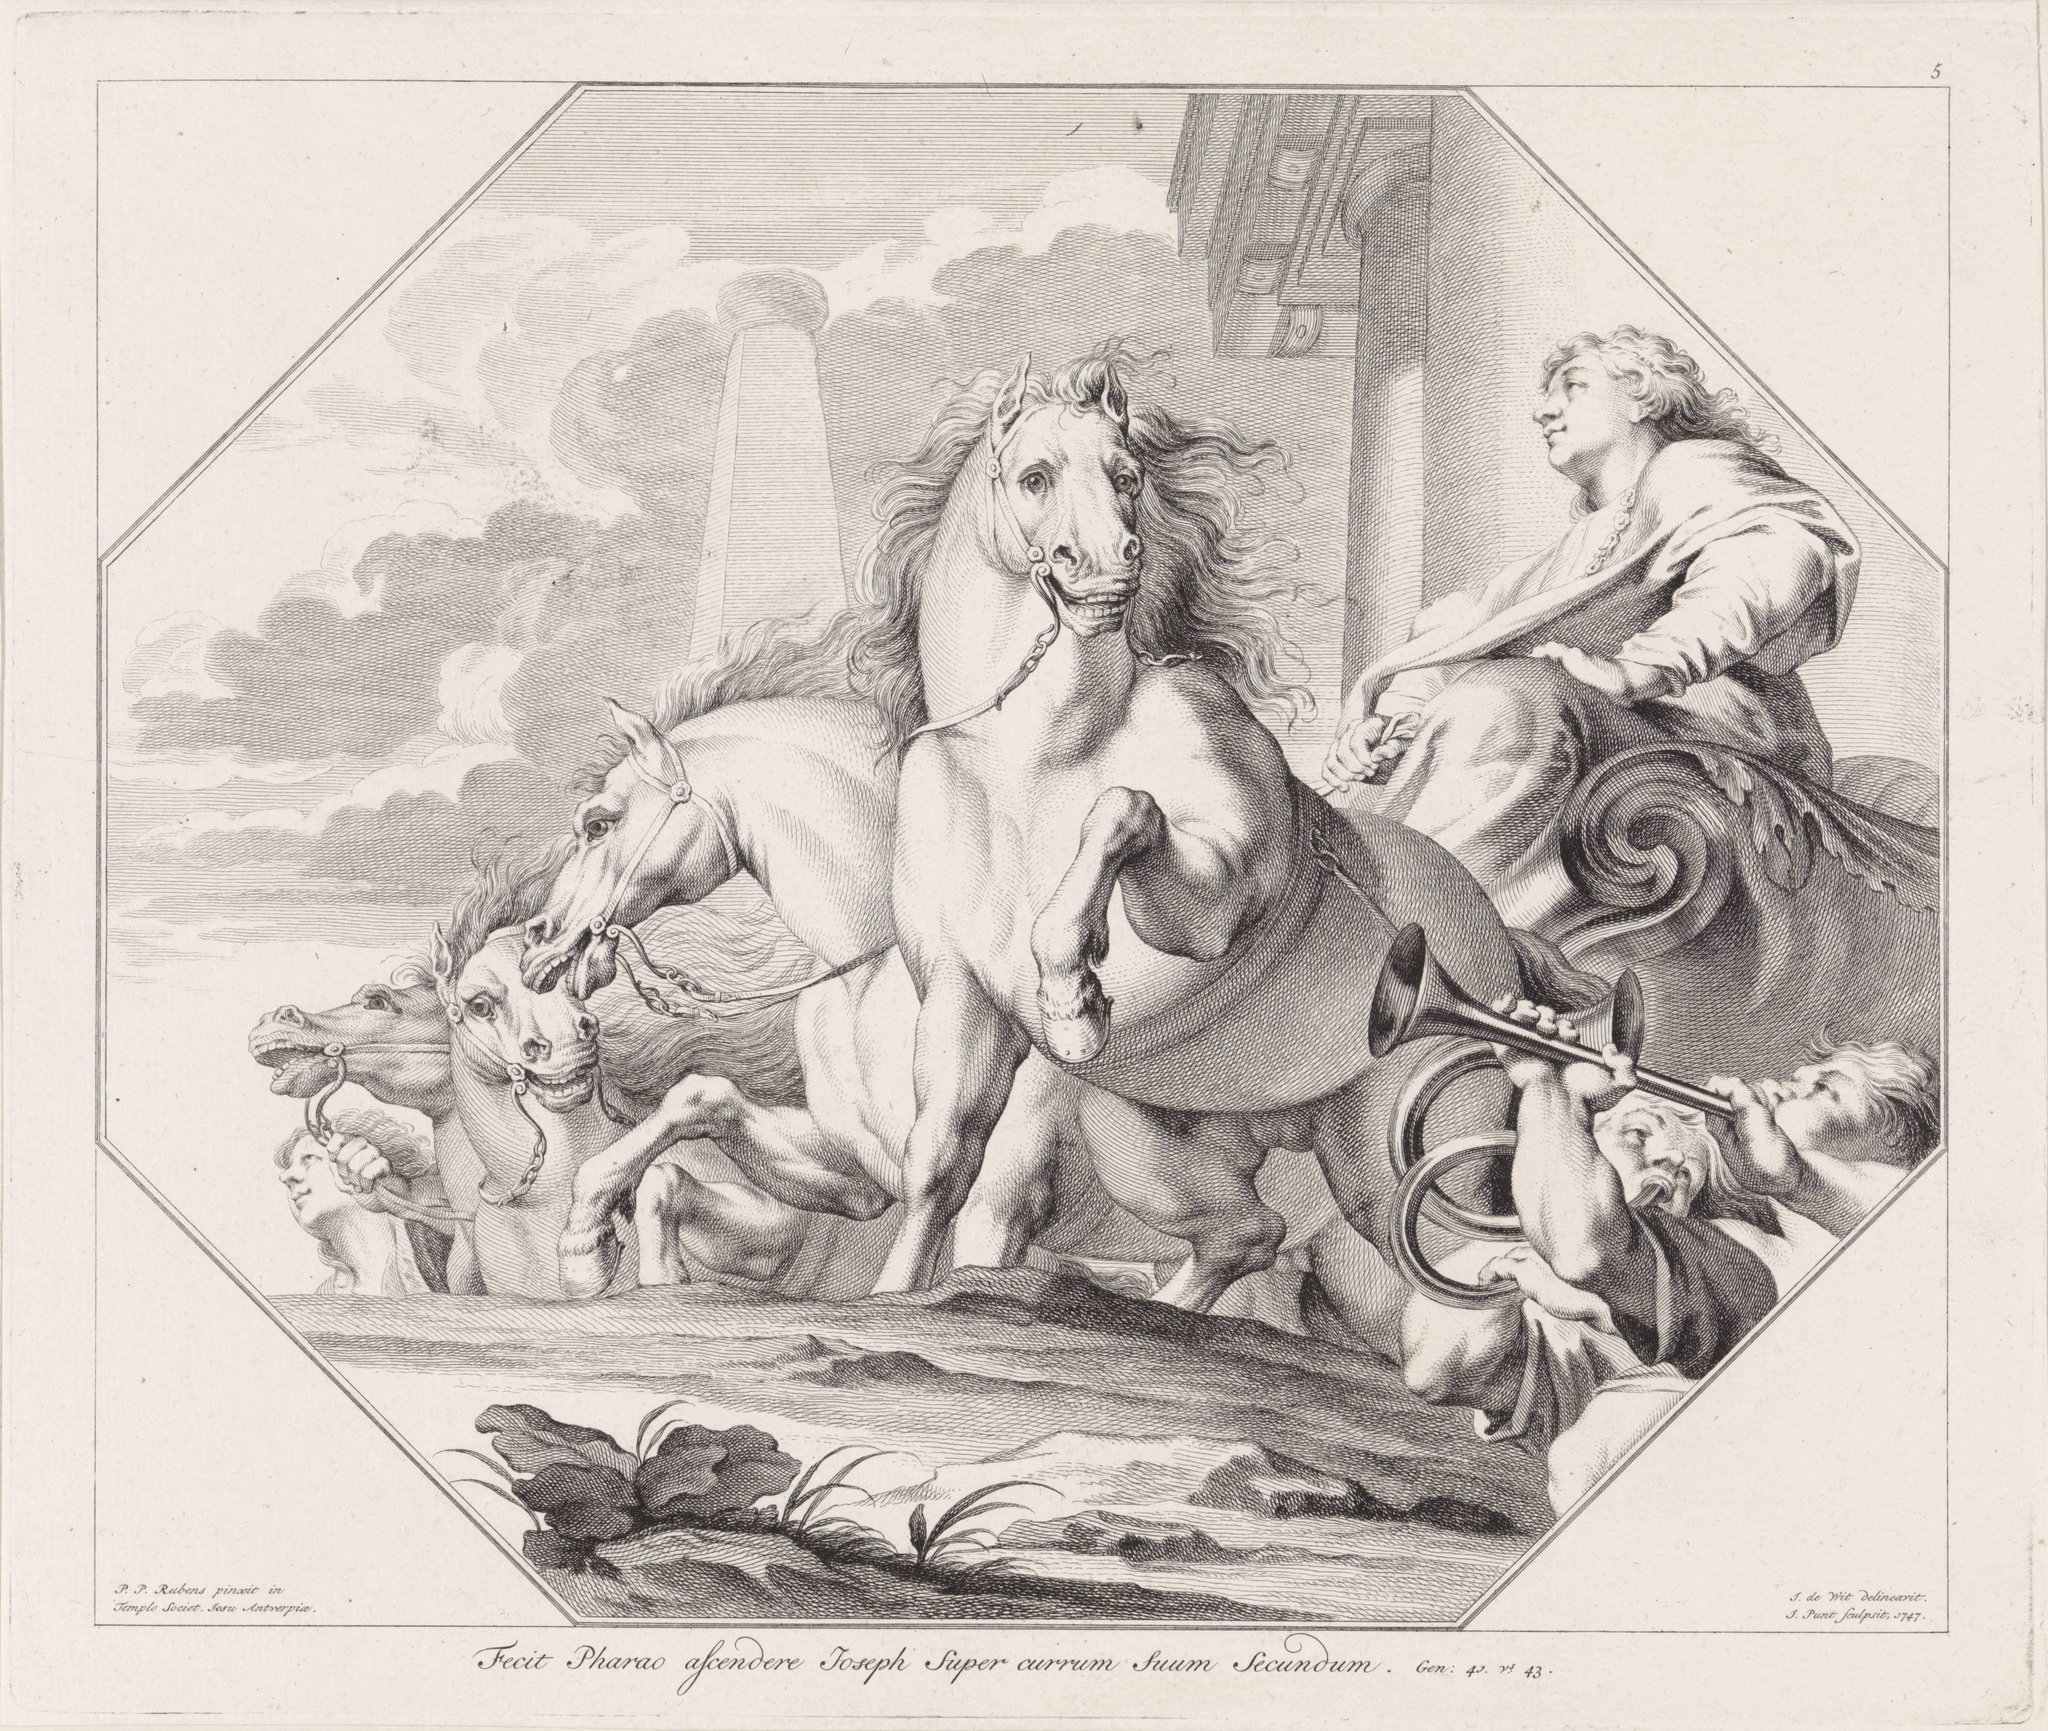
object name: print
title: Jozef in de zegewagen, door Farao aangesteld over heel Egypte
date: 1747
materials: paper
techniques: engraving, etching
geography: amsterdam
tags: triumph of joseph: dressed in a royal attire he rides in one of pharaoh's chariots, preceded by a herald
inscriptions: collector's mark: Lugt 240, date: ‘1747’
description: In koninklijk gewaad zetelt Jozef in een wagen van Farao. Onder de octagonale voorstelling een vers in het Latijn uit Gen. 41:43.